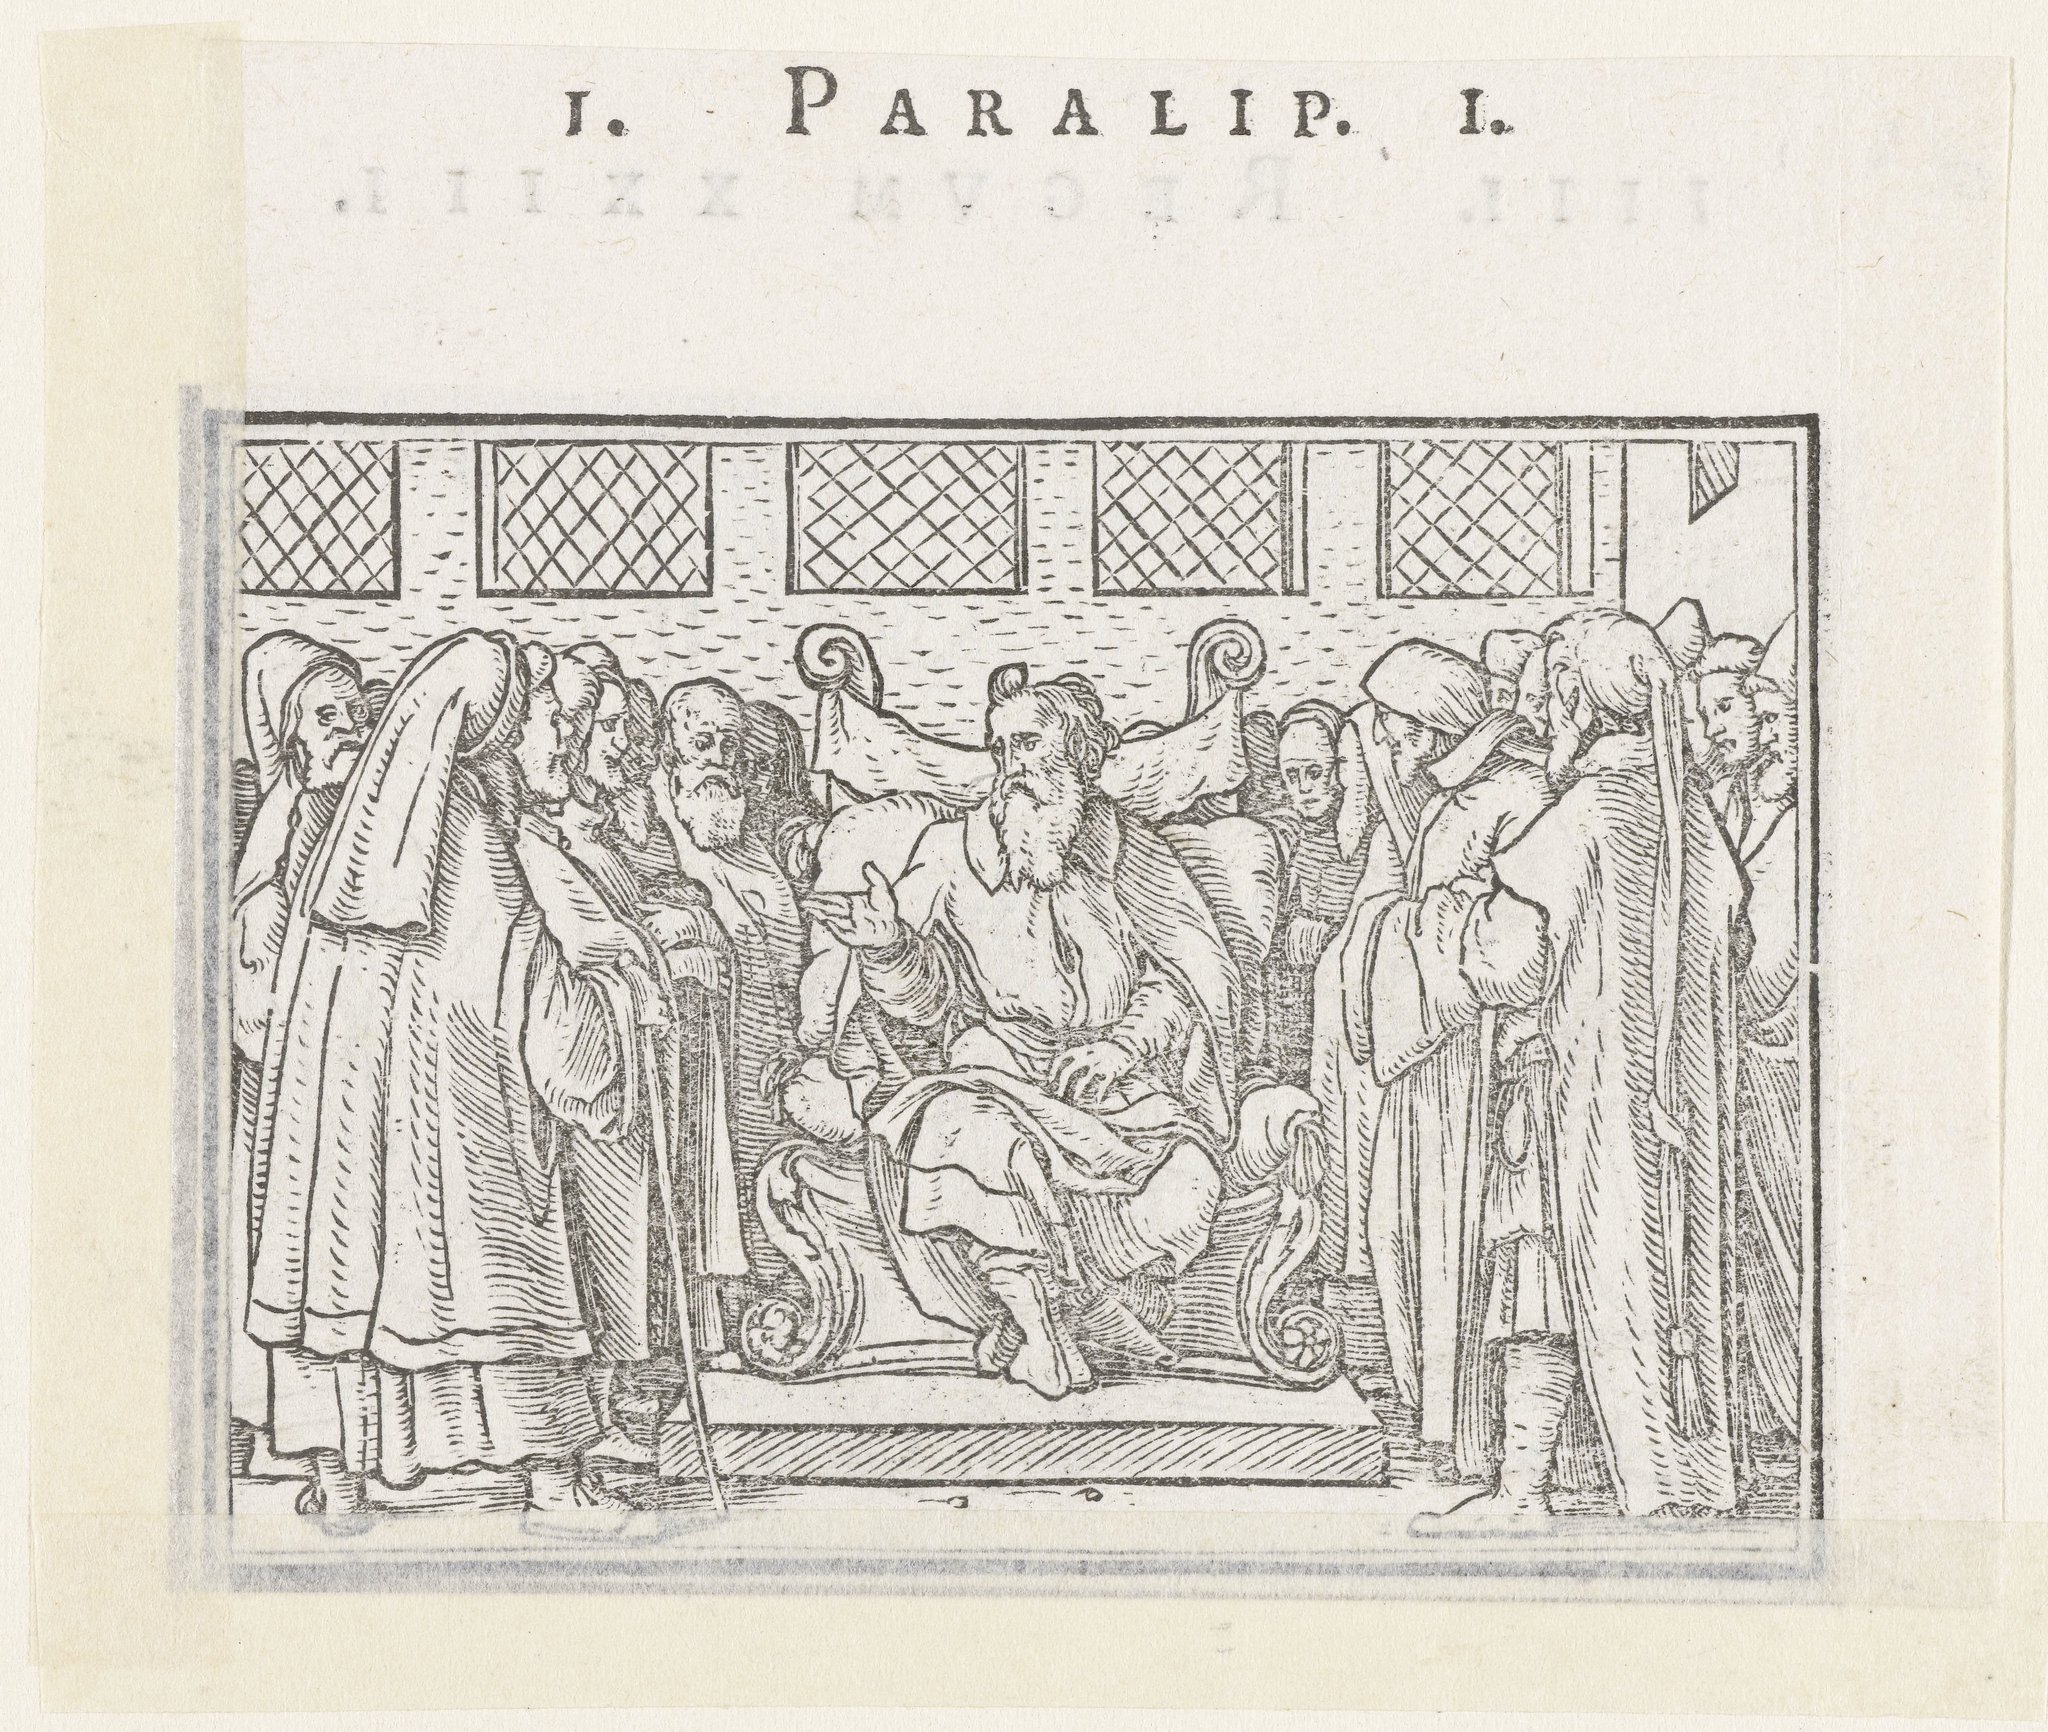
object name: book illustration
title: Oude mannen verenigd rond een troon met stamvader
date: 1538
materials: paper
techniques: woodcut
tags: old man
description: Houtblok voor het eerst gebruikt in: Biblia Utriusque Testamenti iuxta Vulgatam Translationem, Lyon, M. en G. Trechsel (voor Hugo à Porta) 1538. Later in verschillende uitgaven opnieuw gebruikt.